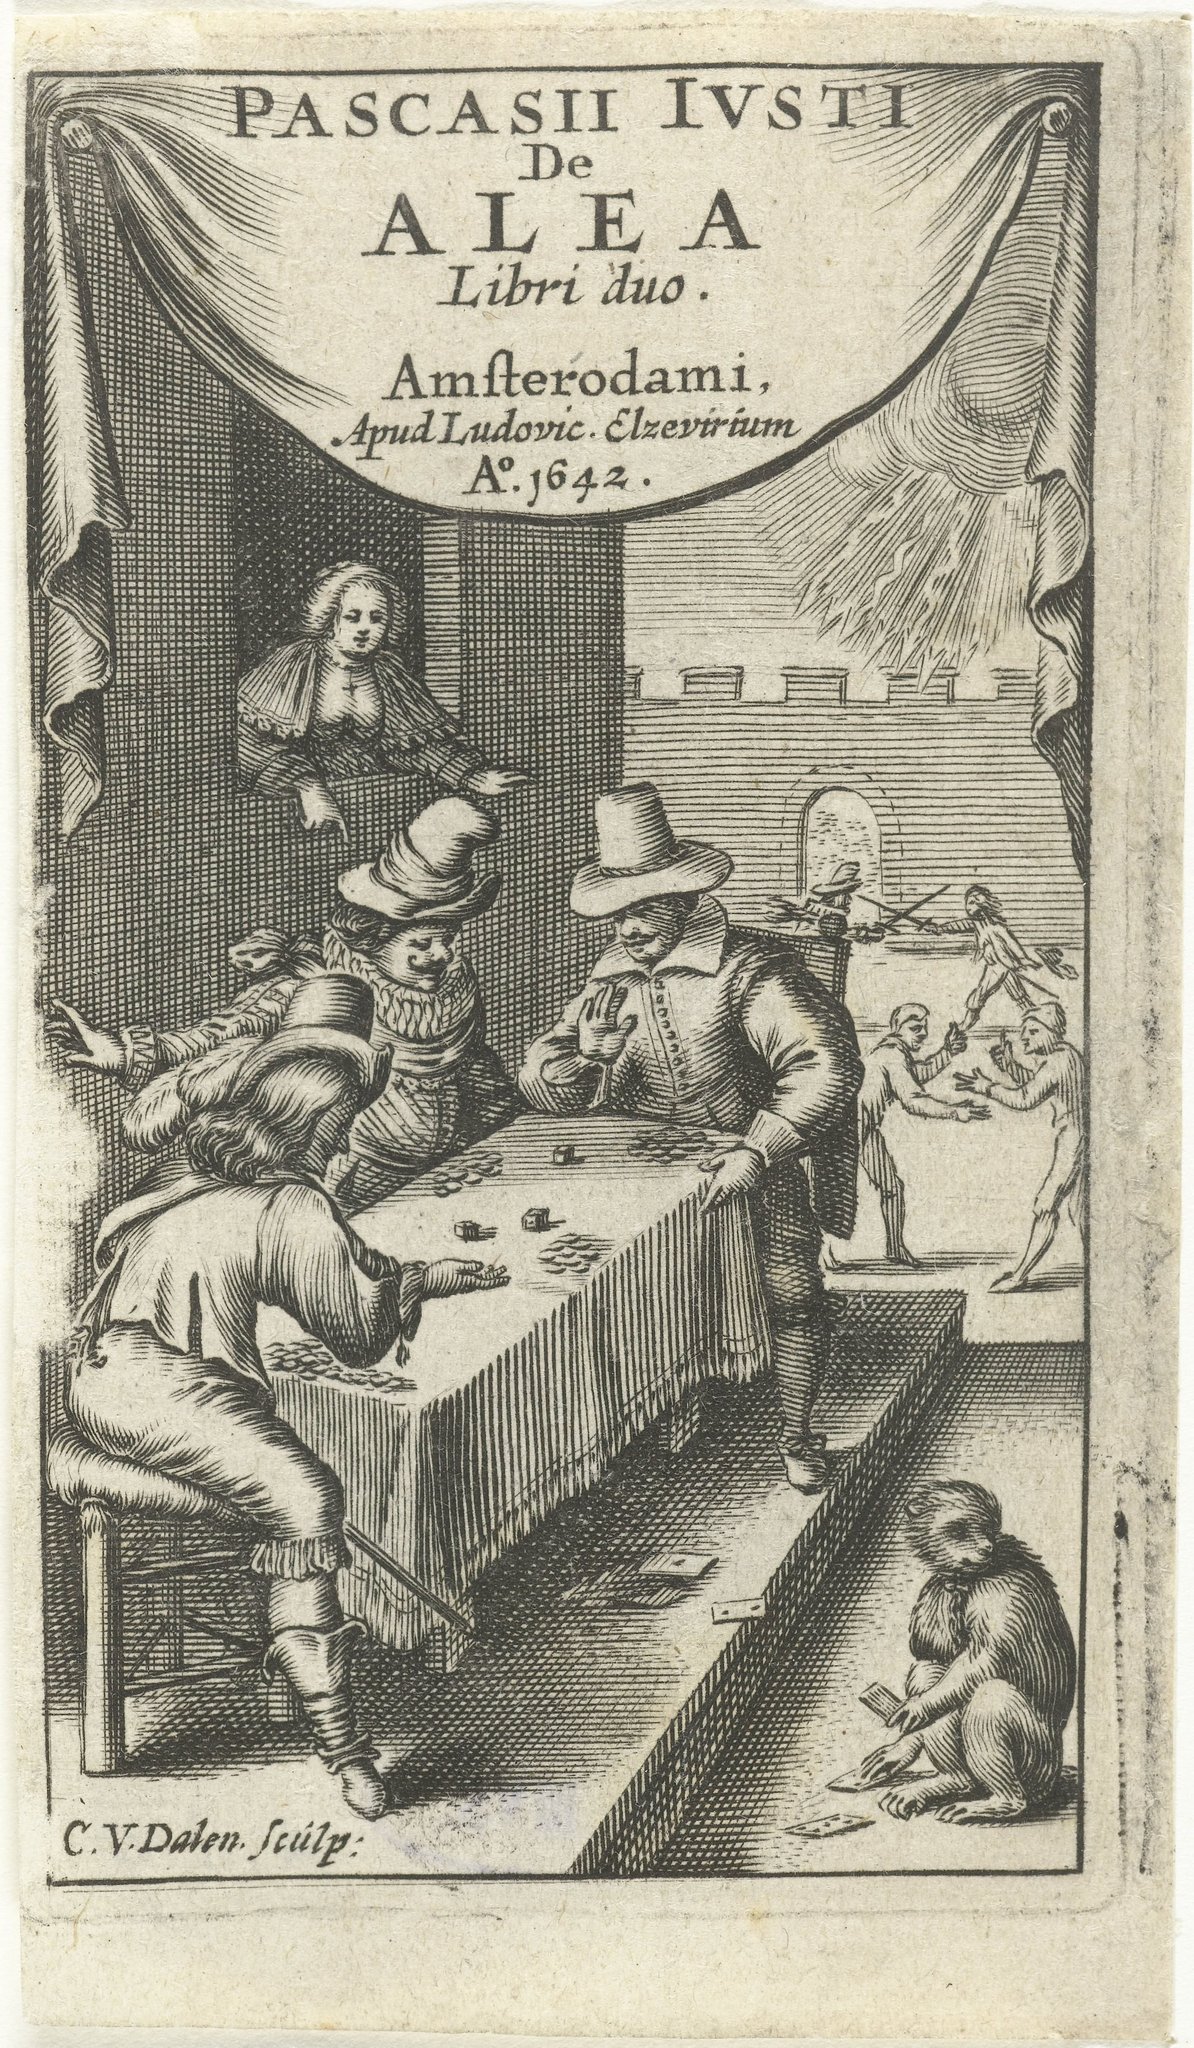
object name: print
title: Mannen spelen dobbelspel, op de grond zit aap met speelkaarten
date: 1642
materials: paper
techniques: engraving, etching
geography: amsterdam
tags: monkeys, apes, dice-games, playing-cards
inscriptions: collector's mark: Lugt 2228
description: Titelpagina voor: Paschier Joostens, De alea libri duo, Lowijs Elzevier (III) (uitgever), Amsterdam 1642